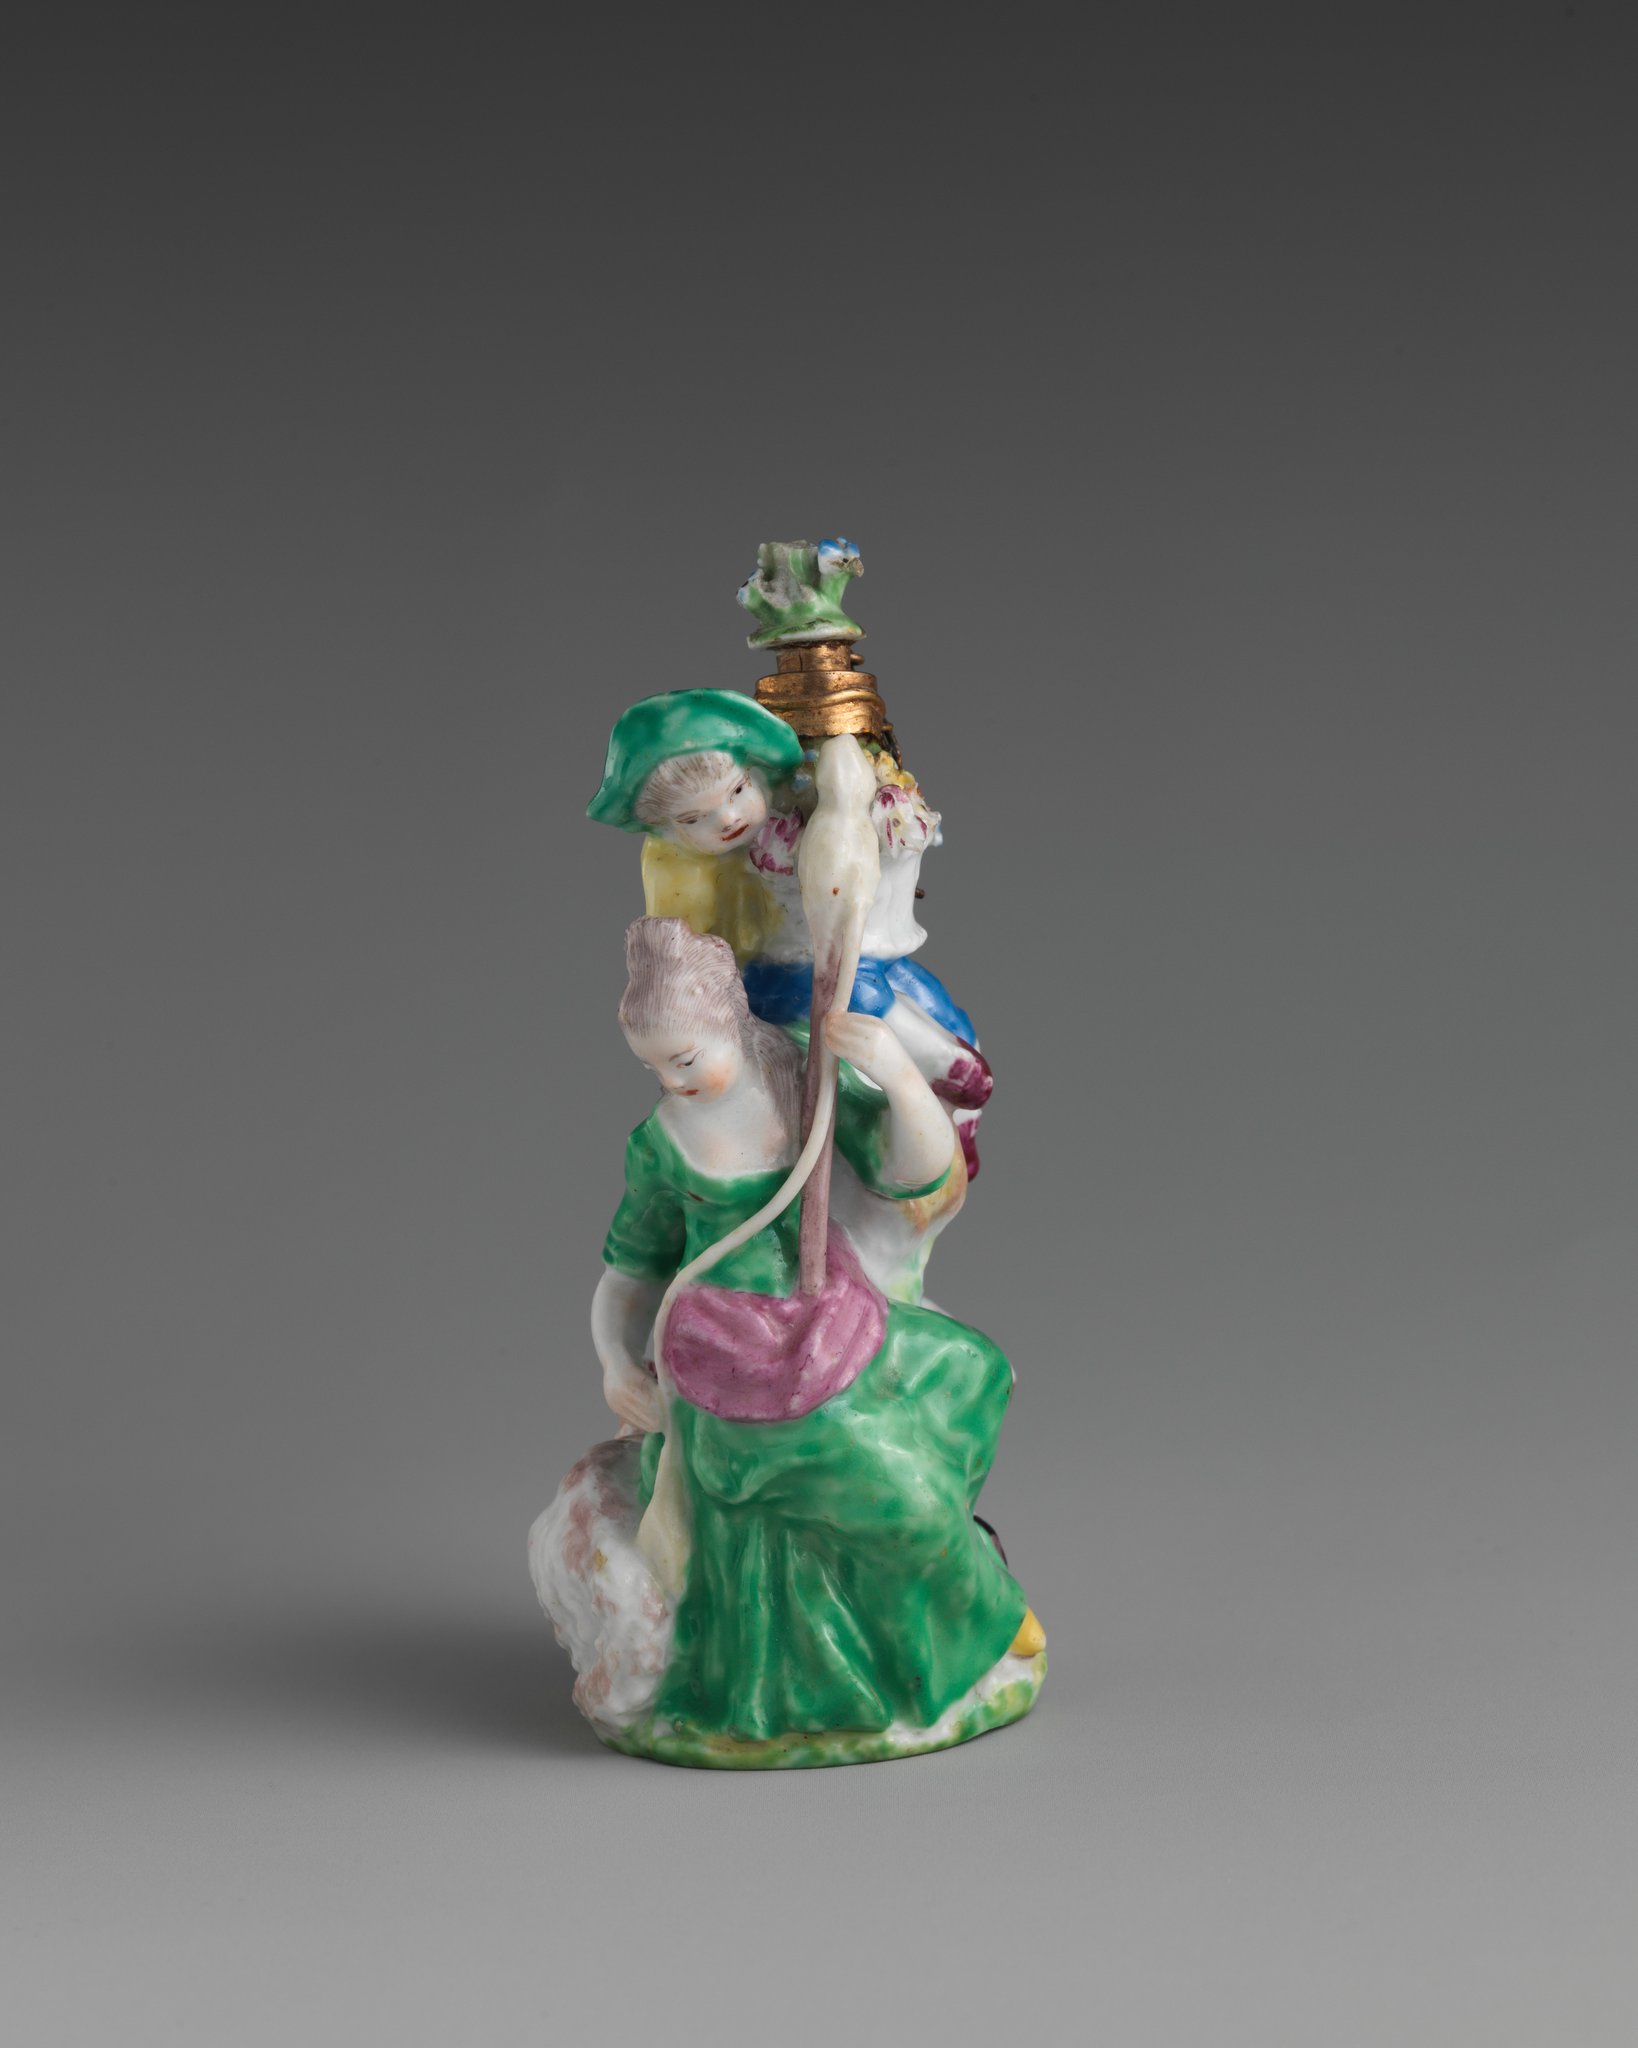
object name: toy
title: Lady with distaff and two boys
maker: chelsea porcelain manufactory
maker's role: factory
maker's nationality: british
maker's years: 1744-1784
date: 1765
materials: soft paste porcelain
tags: boys,women